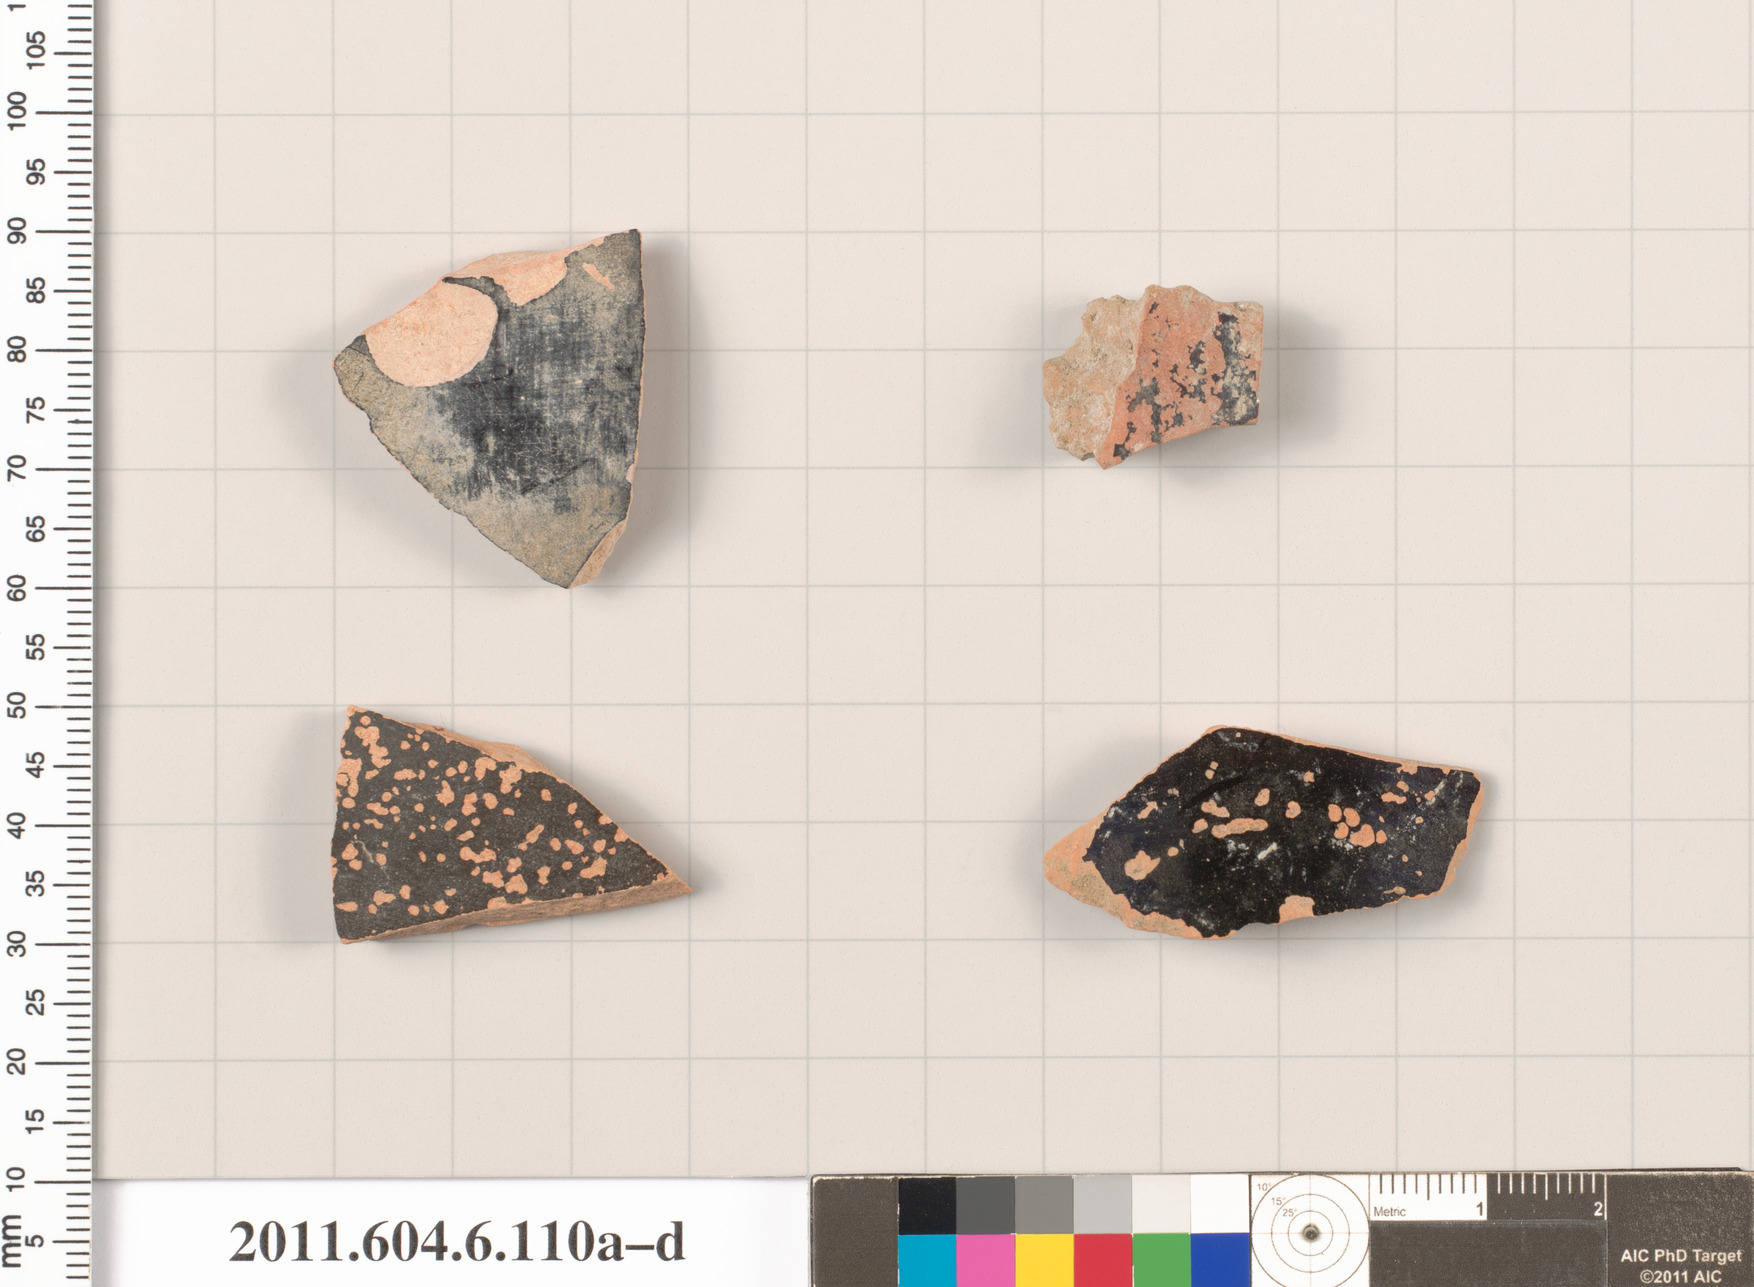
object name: undetermined closed shape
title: Terracotta fragments of closed shapes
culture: greek, attic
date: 600-401 BCE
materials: terracotta